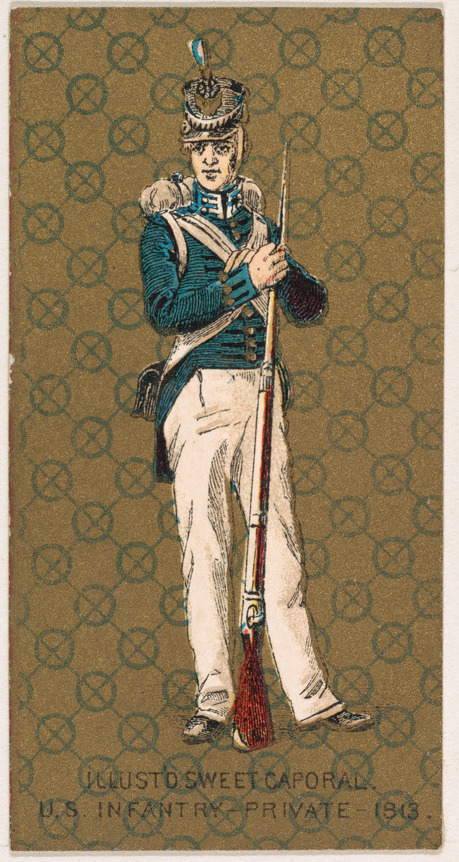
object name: print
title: Private, Infantry, United States Army, 1813, from the Military Series (N224) issued by Kinney Tobacco Company to promote Sweet Caporal Cigarettes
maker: kinney brothers tobacco company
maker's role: publisher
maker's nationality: american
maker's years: 1869-2011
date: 1888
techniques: color lithograph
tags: soldiers,firearms,men